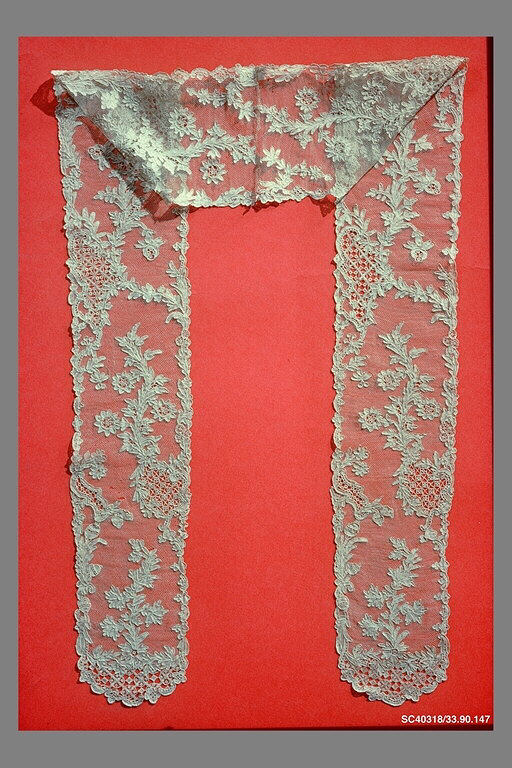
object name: lappet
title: Pair of lappets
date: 1701-1800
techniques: lace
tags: flowers